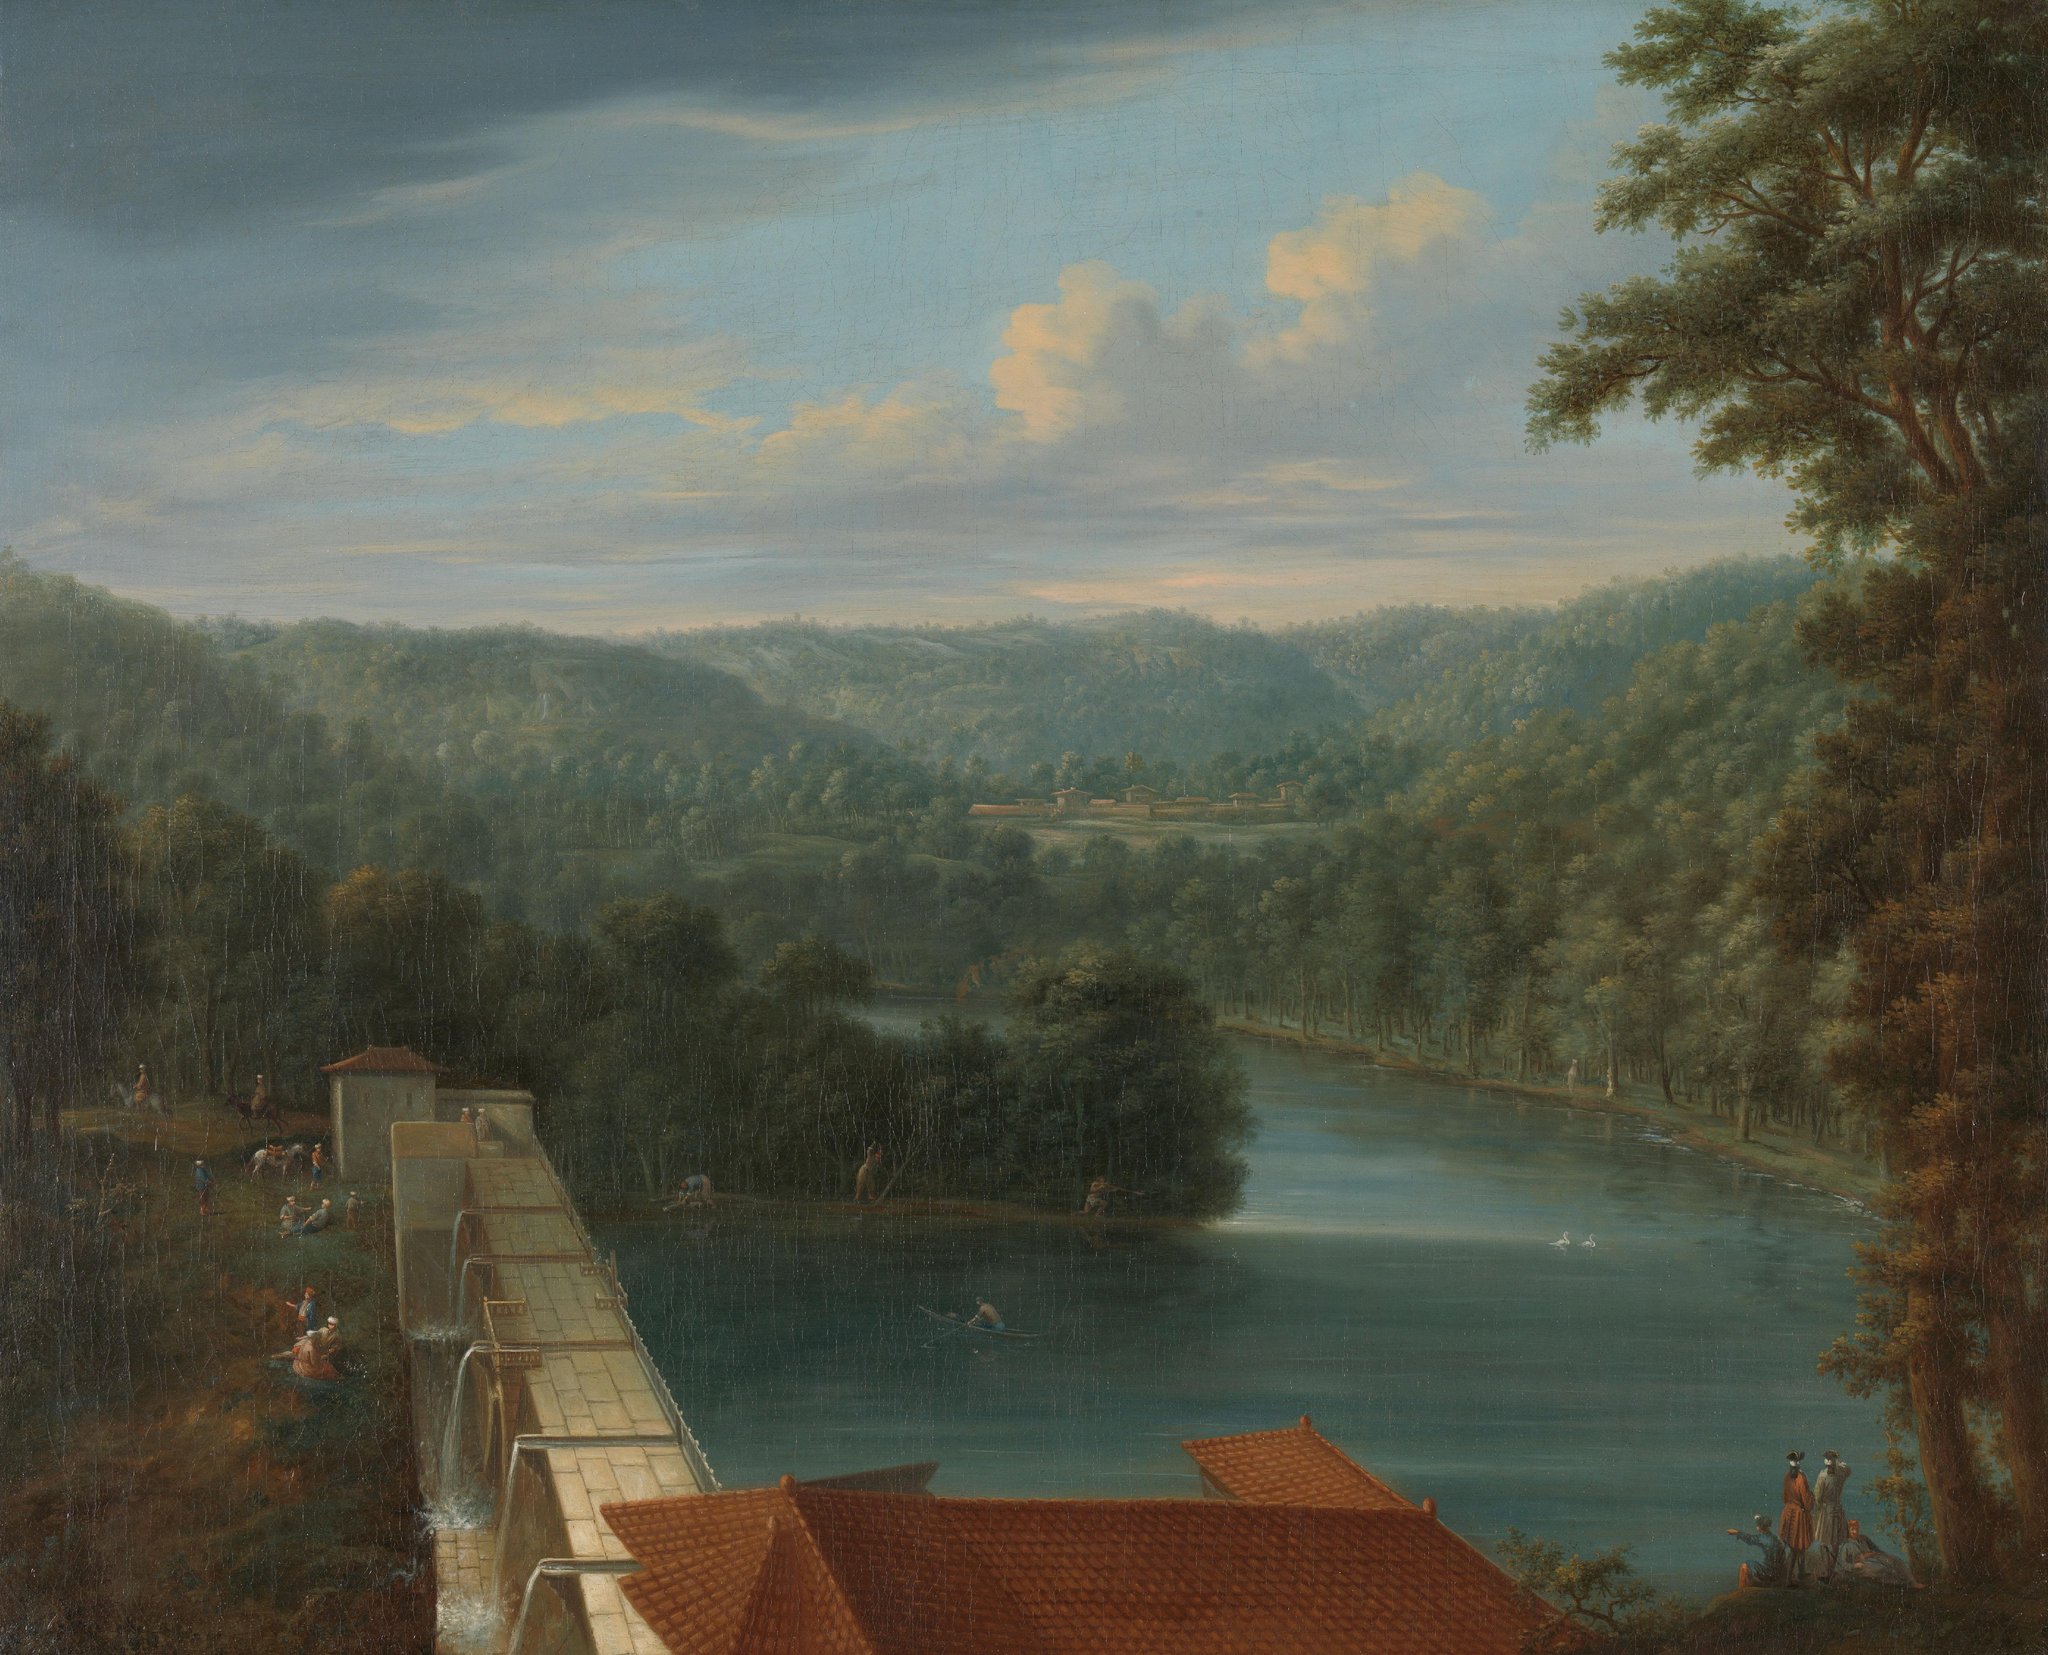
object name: painting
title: The water reservoirs, known as the Bends, in the Forest of Belgrado near Istanbul.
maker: johann christian vollerdt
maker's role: painter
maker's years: 1708-1769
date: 1744-1763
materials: canvas, oil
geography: dresden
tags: dammed-up lake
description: Calkoen owned a country house in Belgrade Forest, north of Istanbul. Vanmour painted that landscape, from which Vollerdt made this copy. Calkoen met Vollerdt in Dresden (his next diplomatic post), where he planned once again to acquire a large number of paintings by a single artist. He probably had Vollerdt copy Vanmour’s painting to assess his skills.